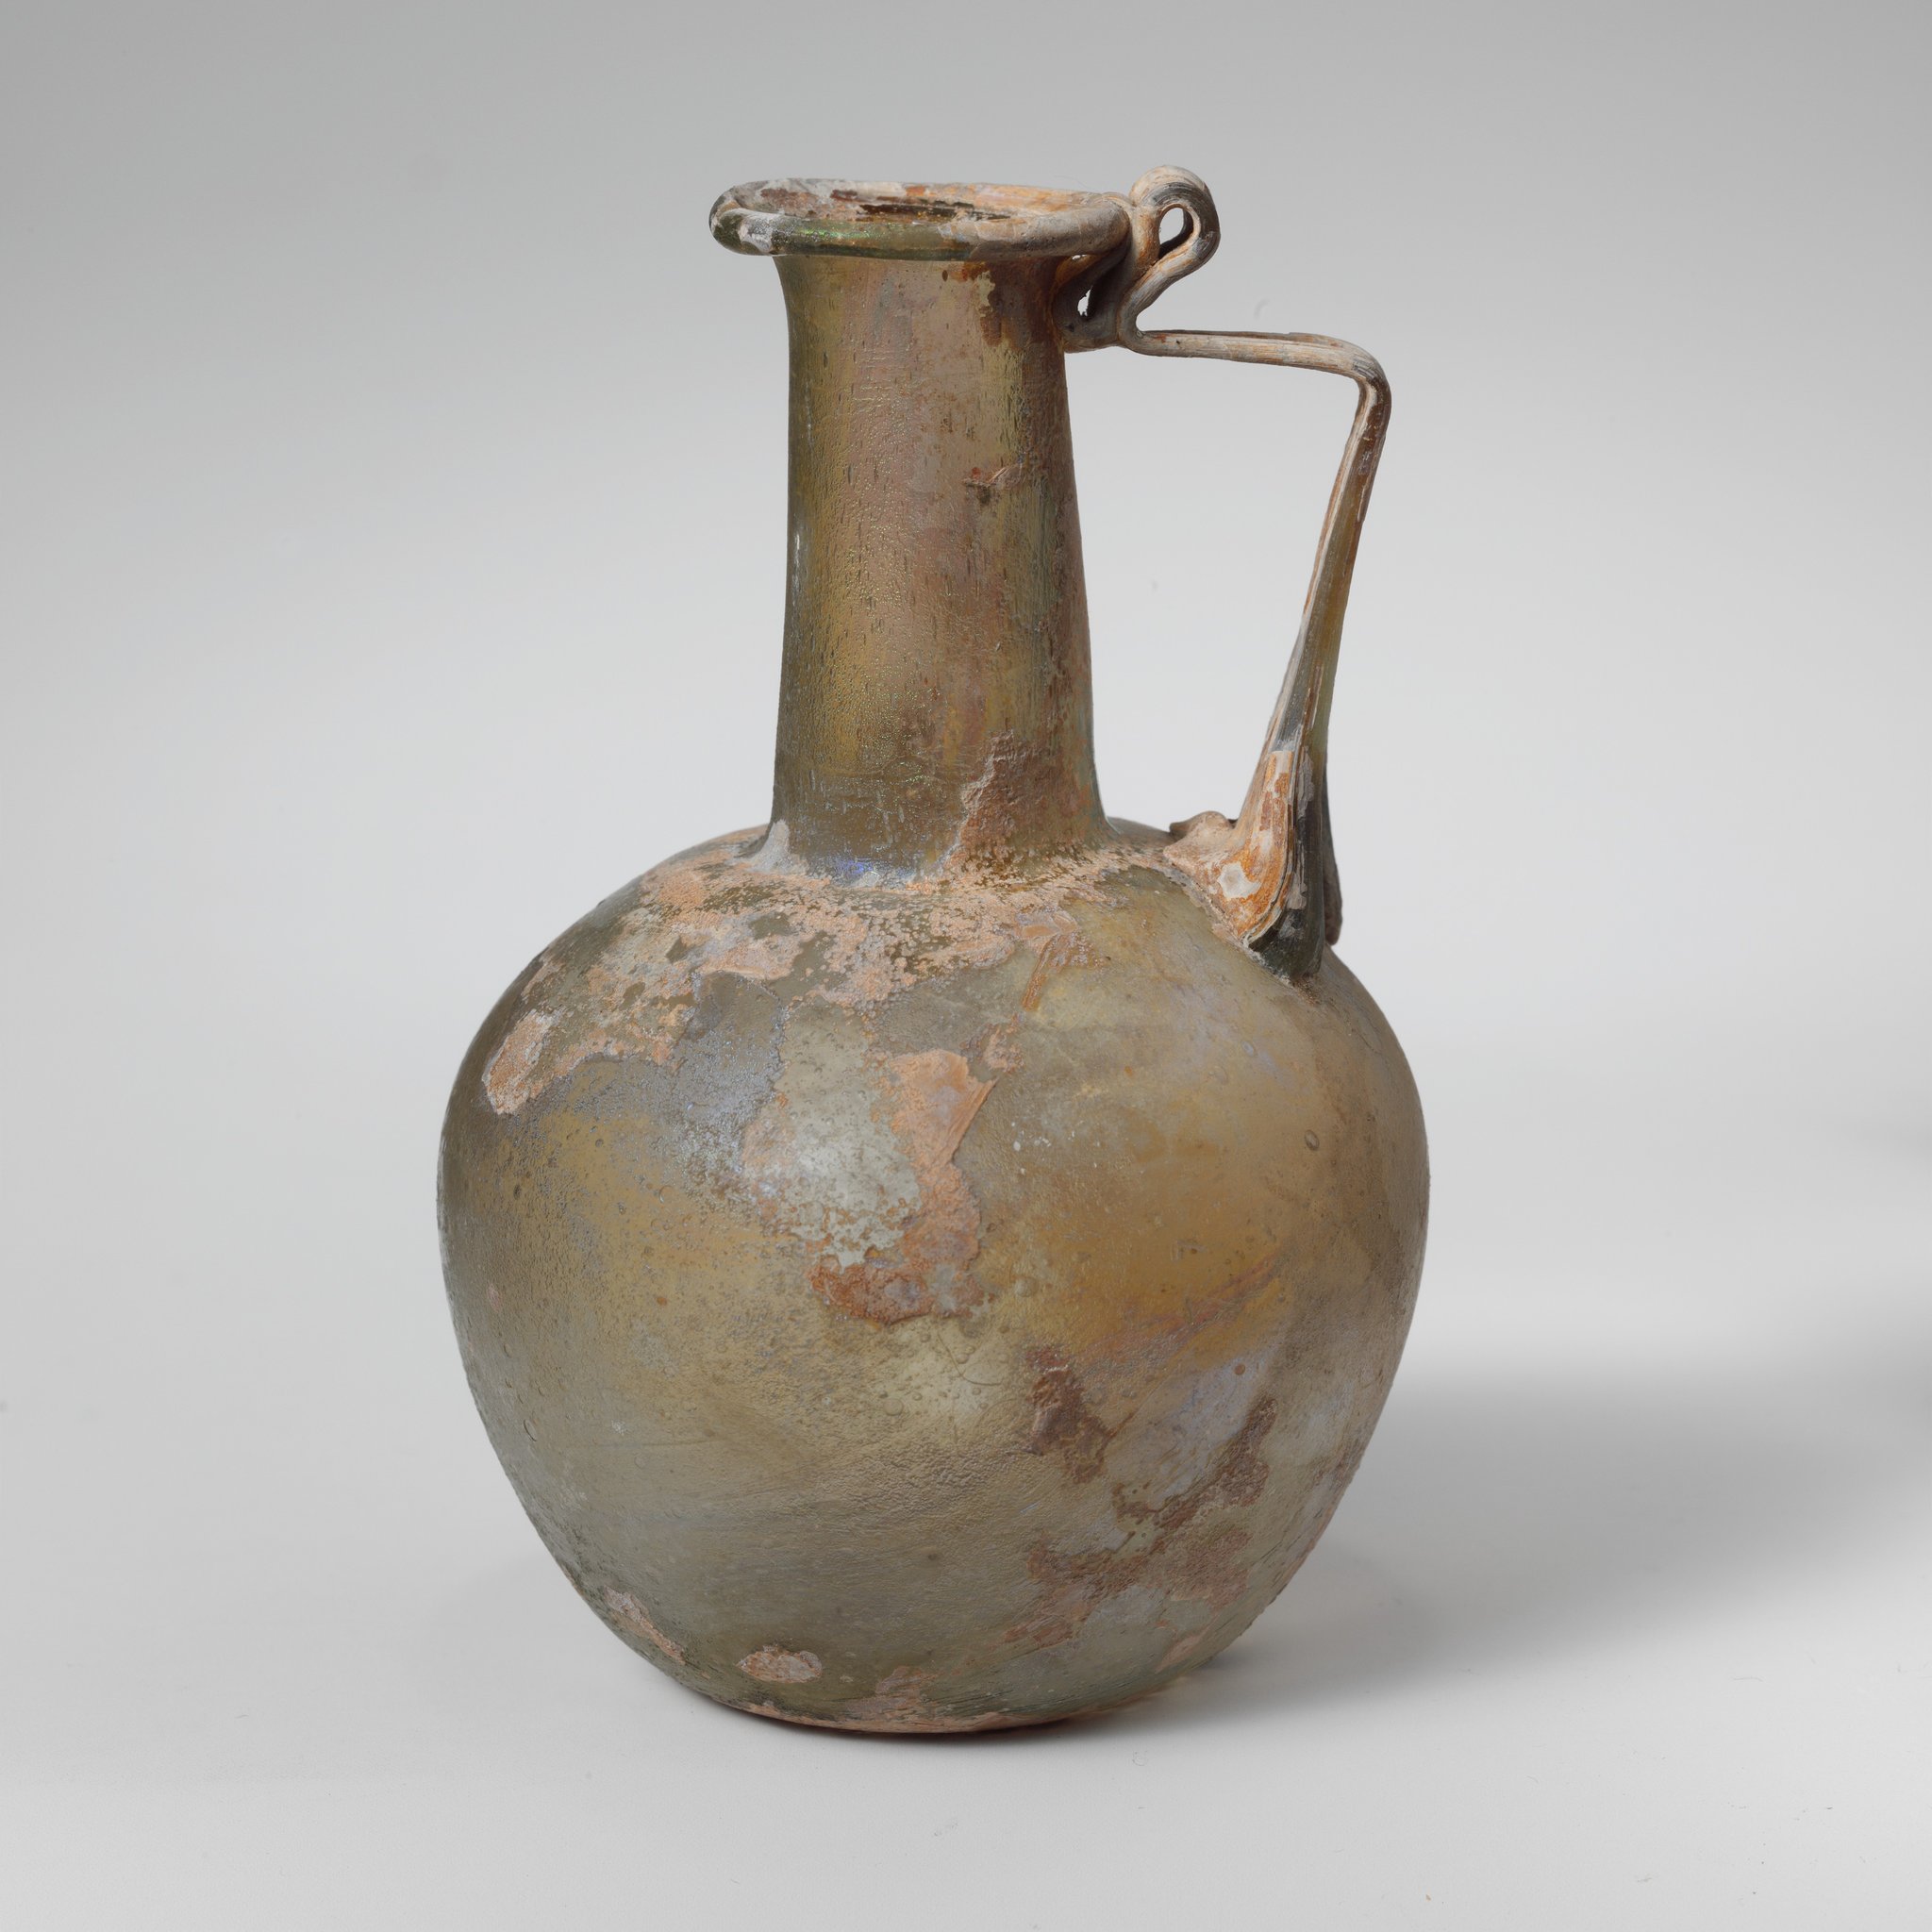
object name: jug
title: Glass jug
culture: roman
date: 101-300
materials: glass